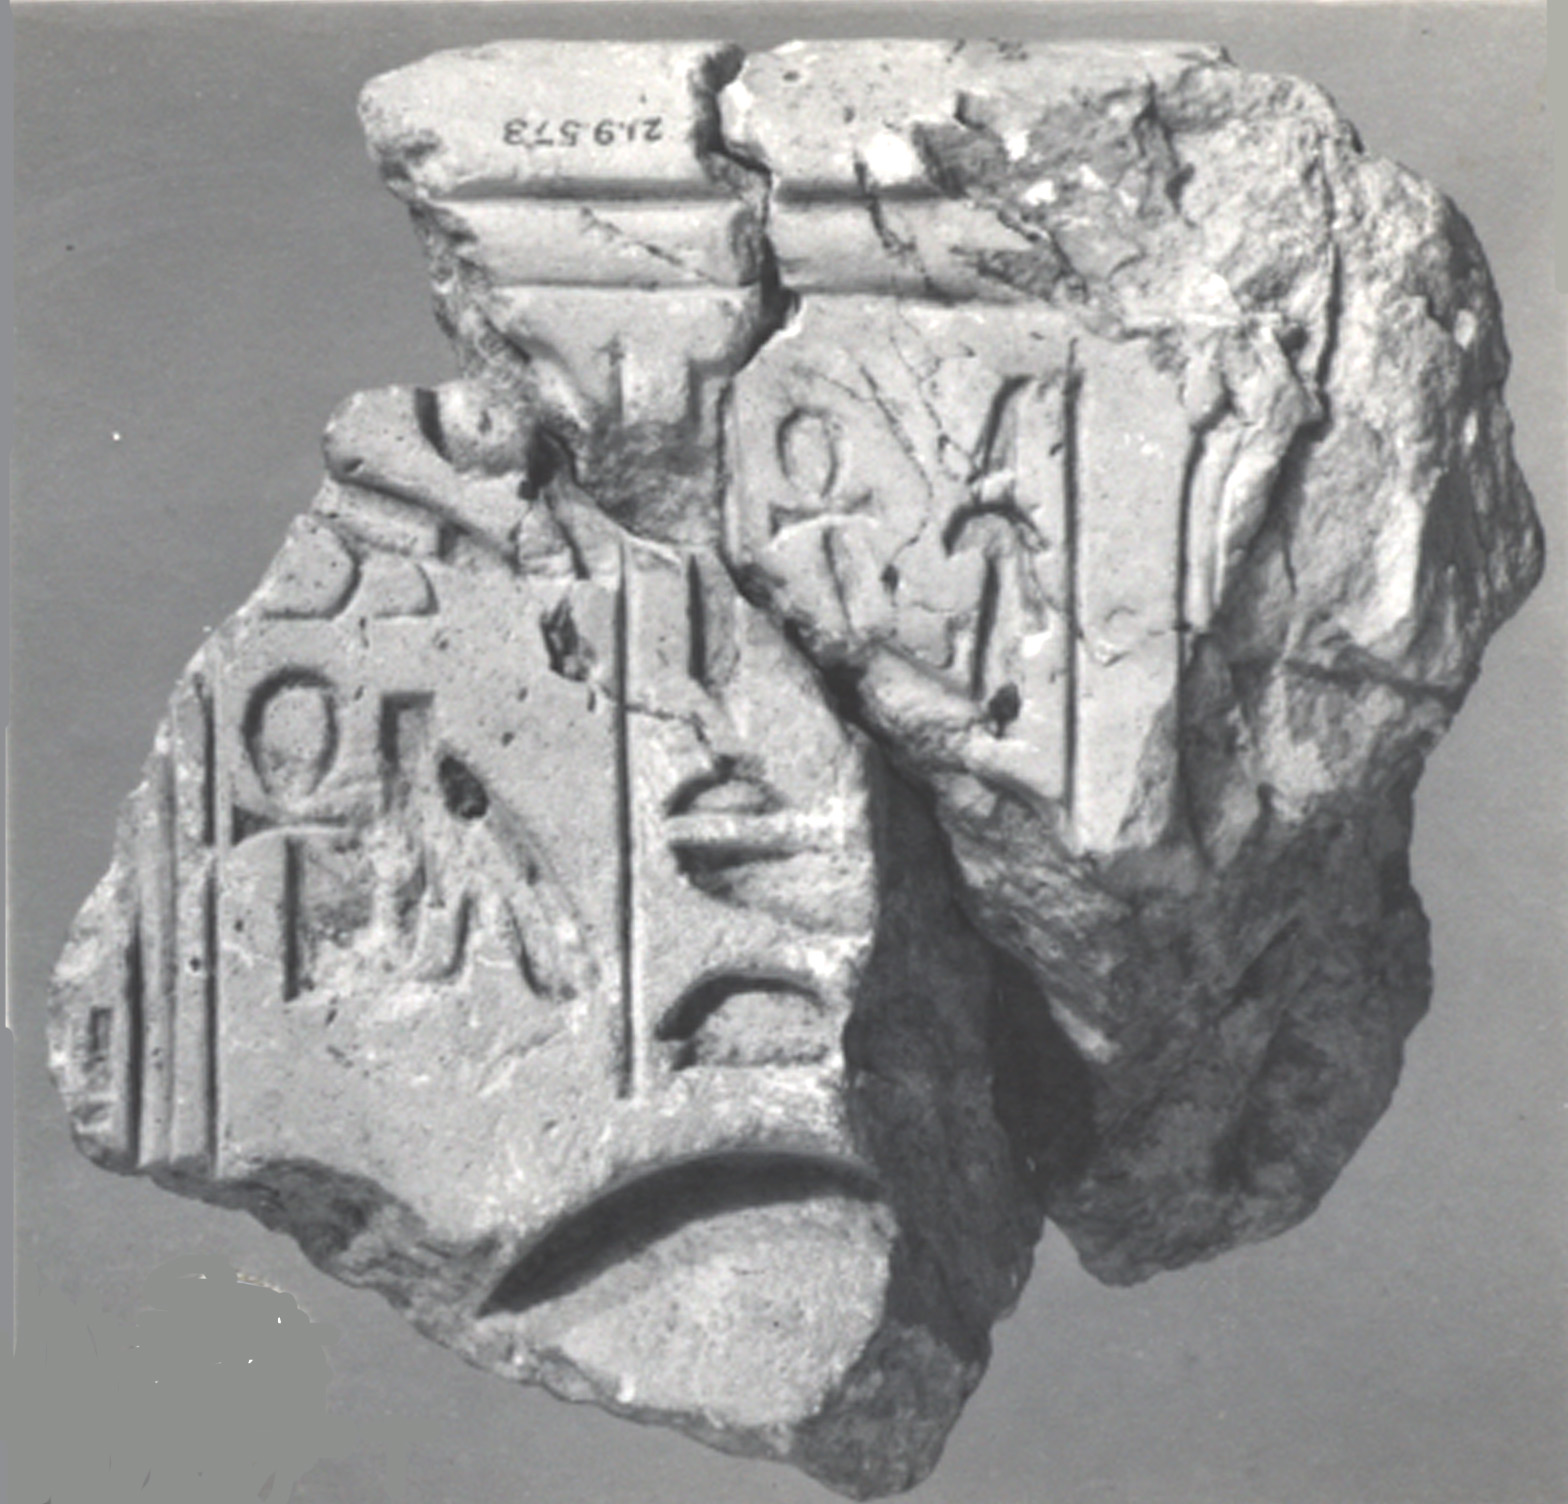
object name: balustrade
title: Balustrade fragment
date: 1353-1336 BCE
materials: limestone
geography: egypt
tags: hieroglyphs